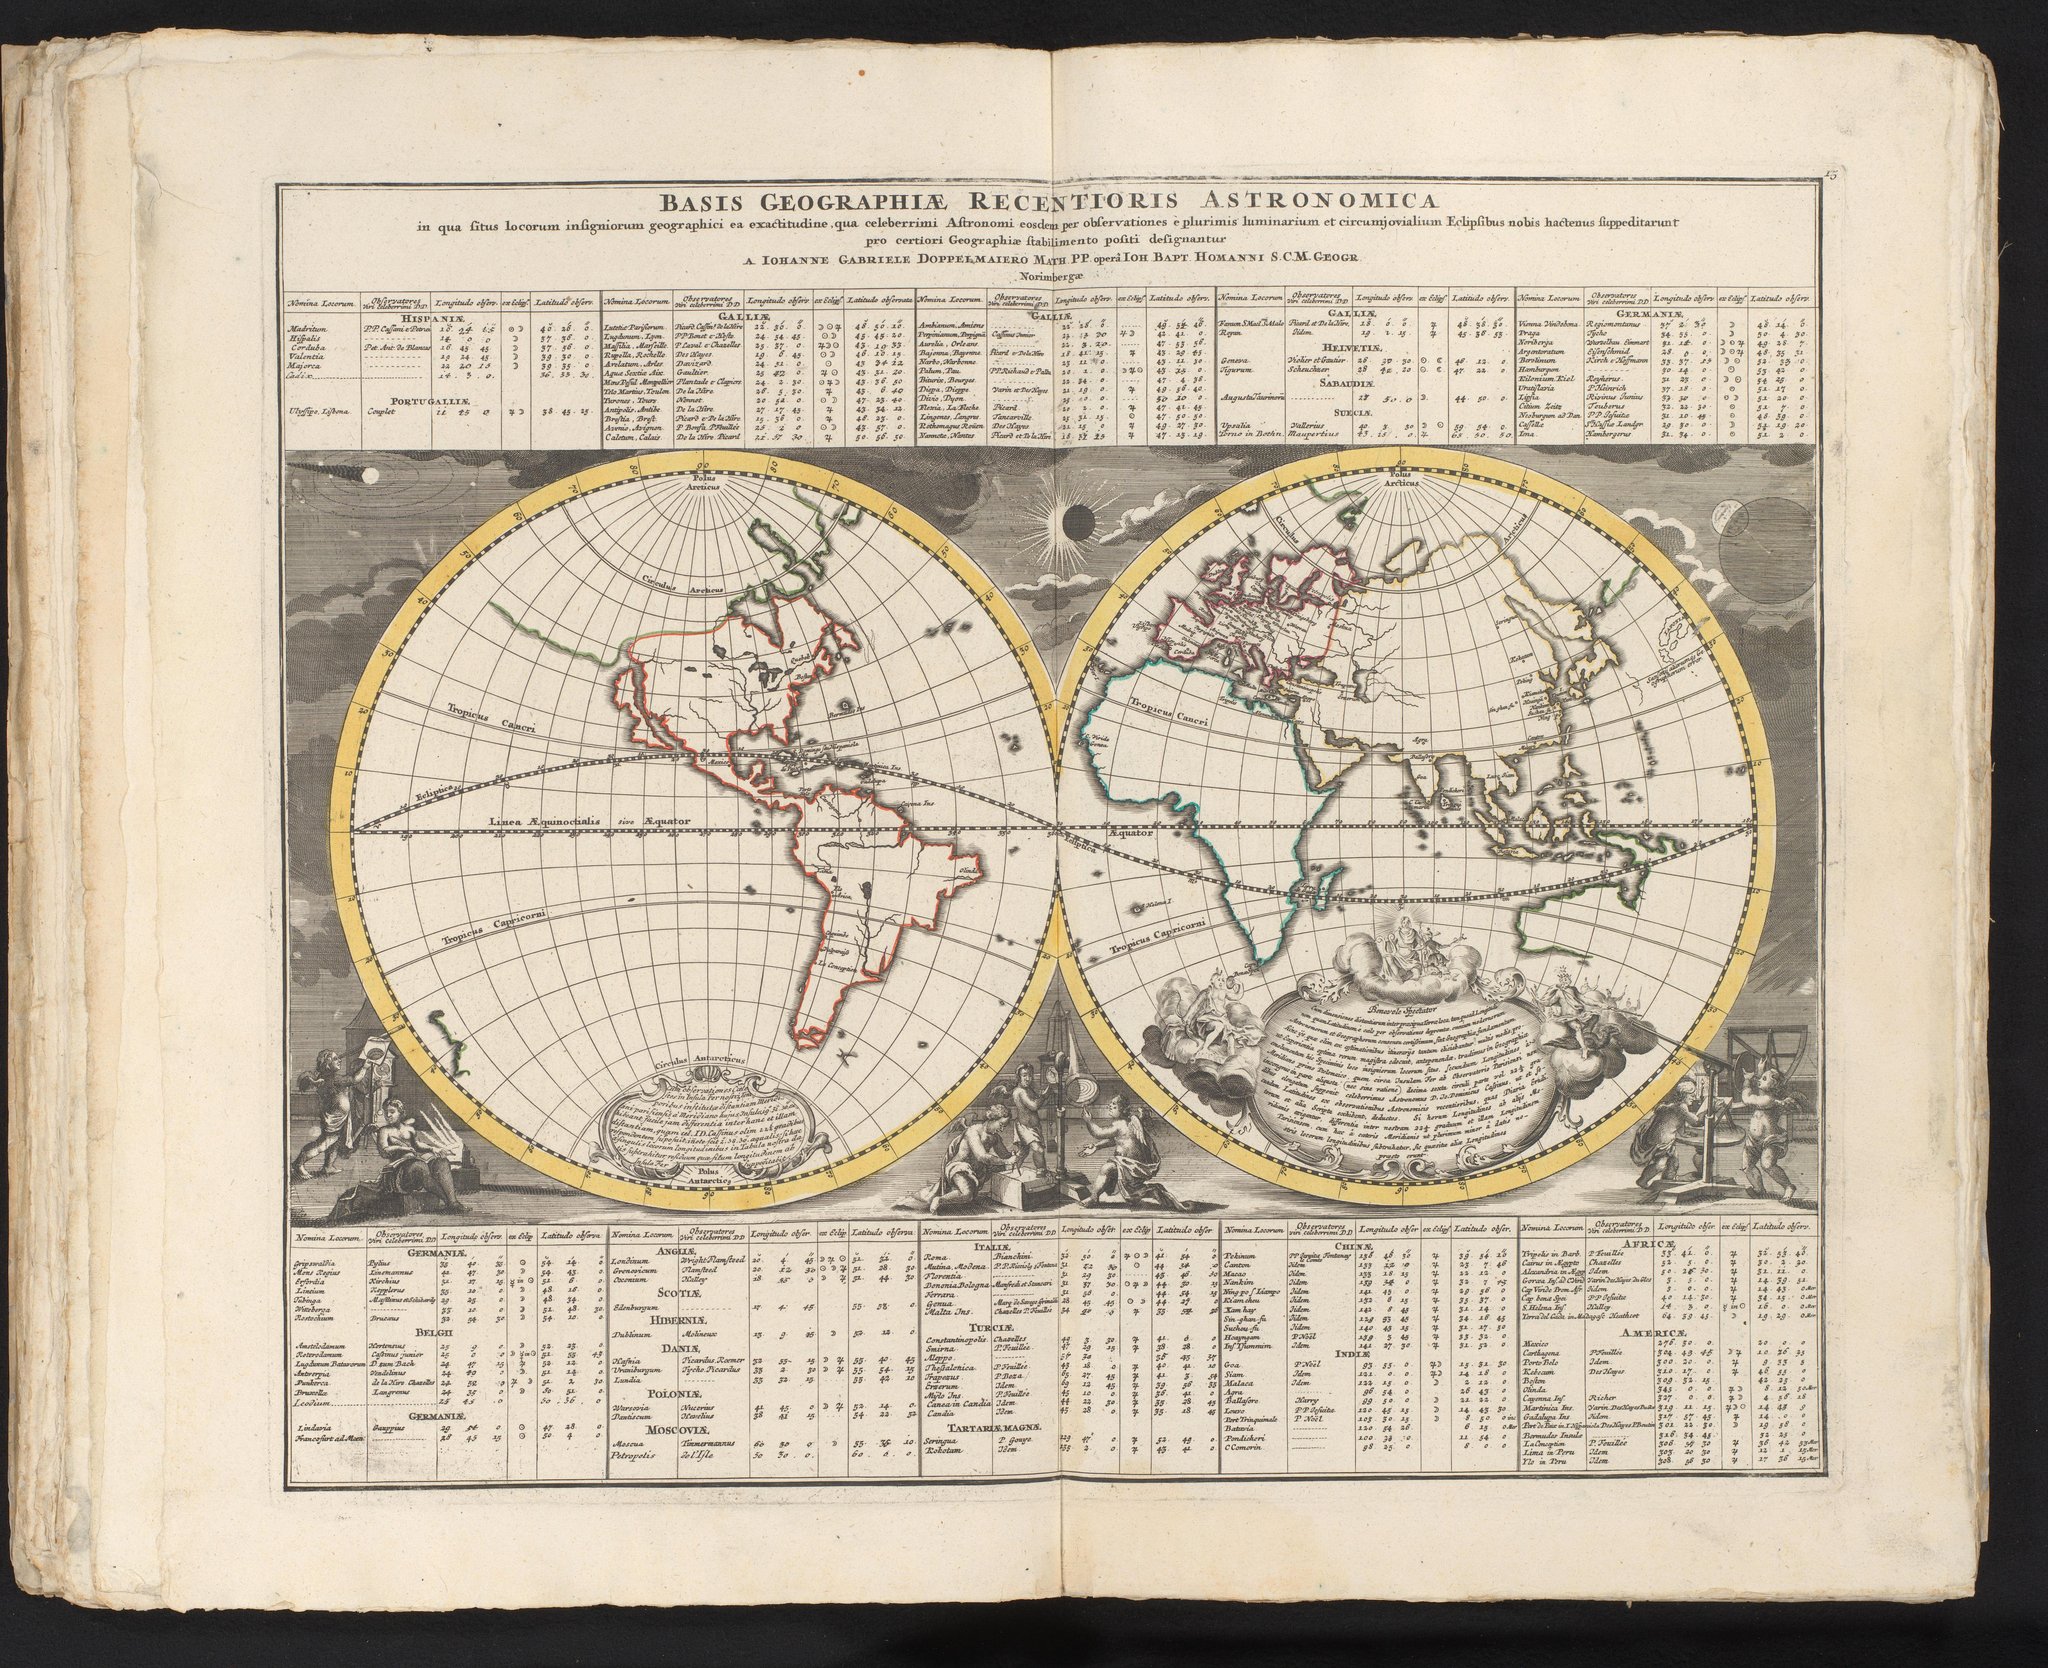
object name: print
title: Basis geographiae recentioris astronomica in qua situs locorum insigniorum (...)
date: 1742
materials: paper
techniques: engraving, etching, hand coloring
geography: nuremberg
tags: map of the world